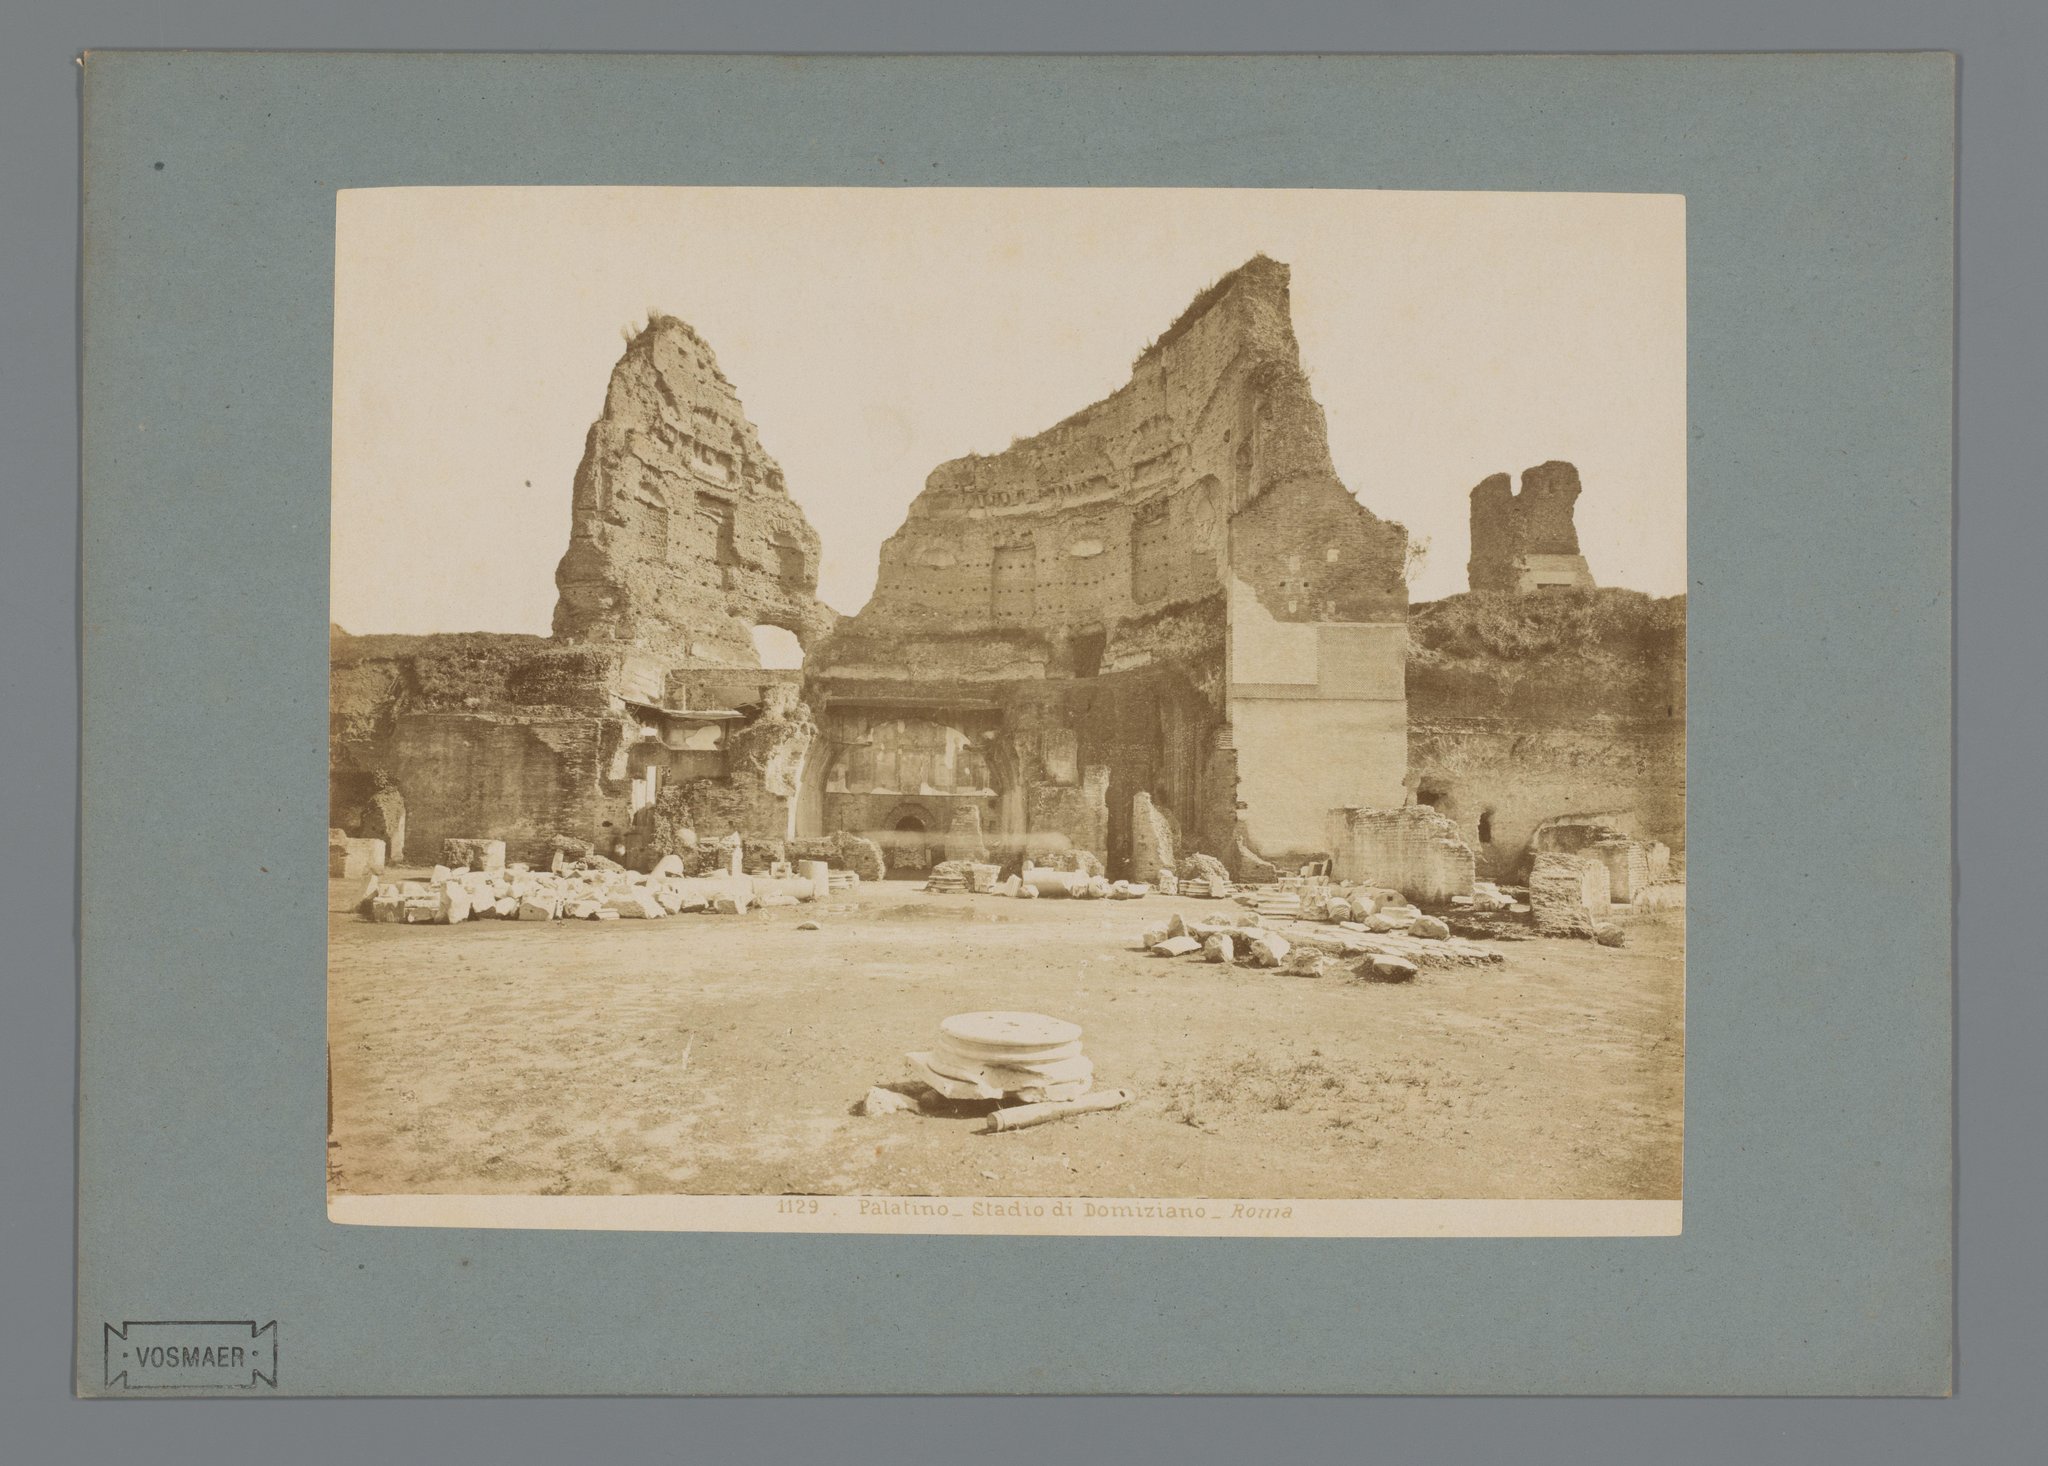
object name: photograph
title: Gezicht op de Hippodroom van Domitianus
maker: Anonymous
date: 1851-1900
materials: cardboard, paper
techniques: albumen print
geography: palatine hill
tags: ruin of a building ~ architecture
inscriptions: number: ‘1129.’, collector's mark: ‘VOSMAER’